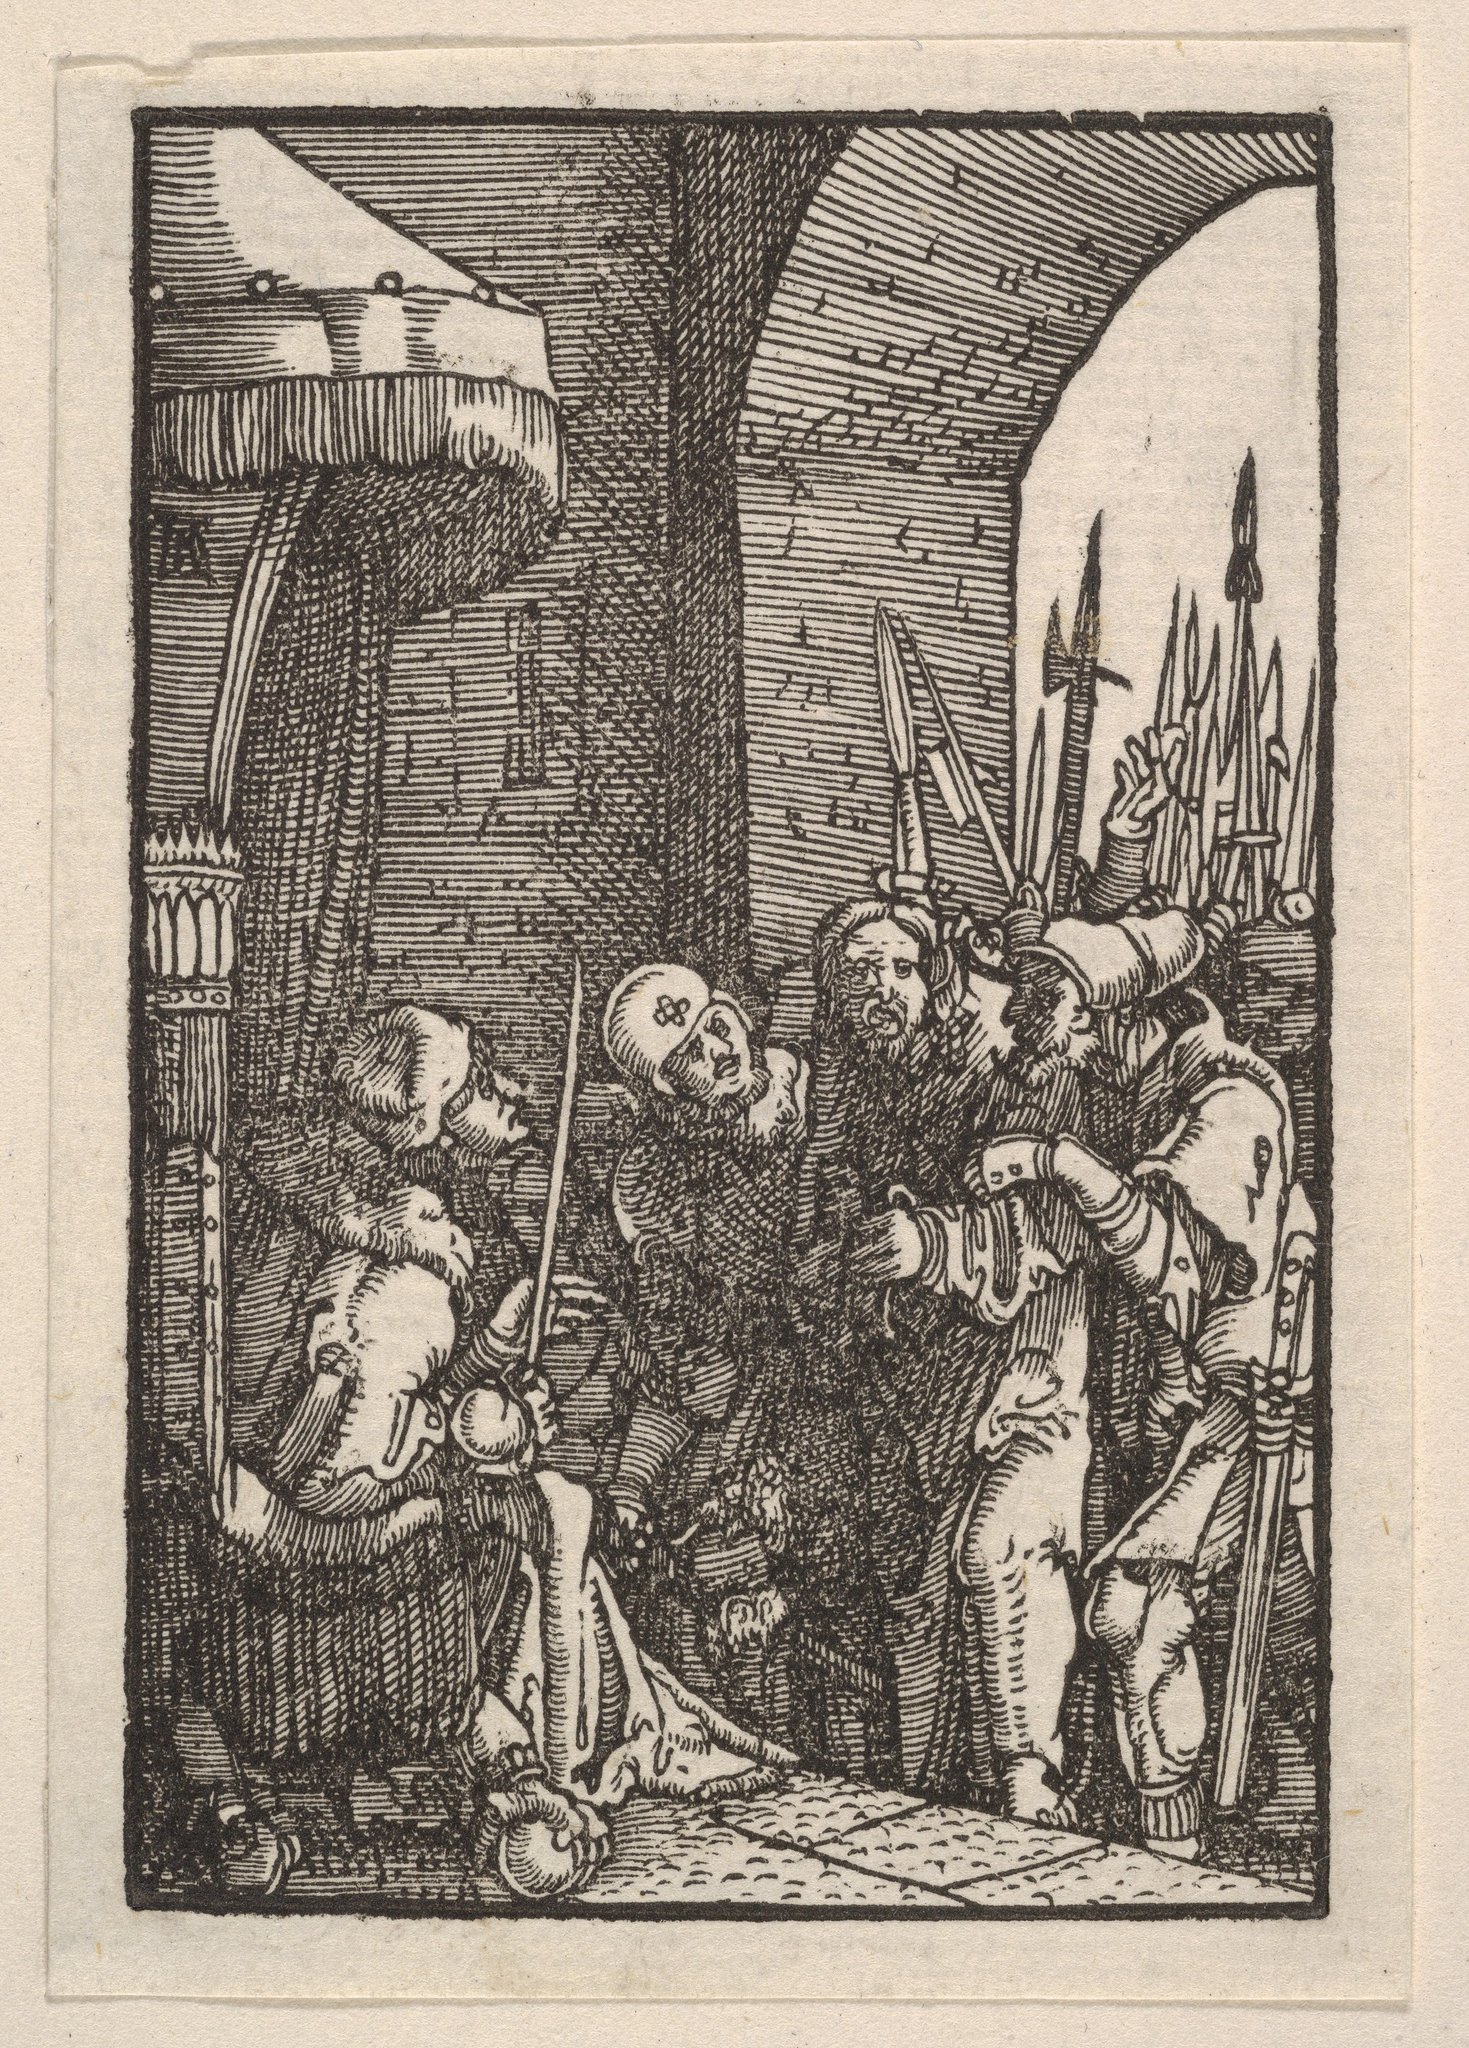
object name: print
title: Christ Before Pilate, from "The Fall and Salvation of Mankind Through the Life and Passion of Christ"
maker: albrecht altdorfer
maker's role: artist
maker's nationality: german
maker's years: 1480-1538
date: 1513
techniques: woodcut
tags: soldiers,men,christ